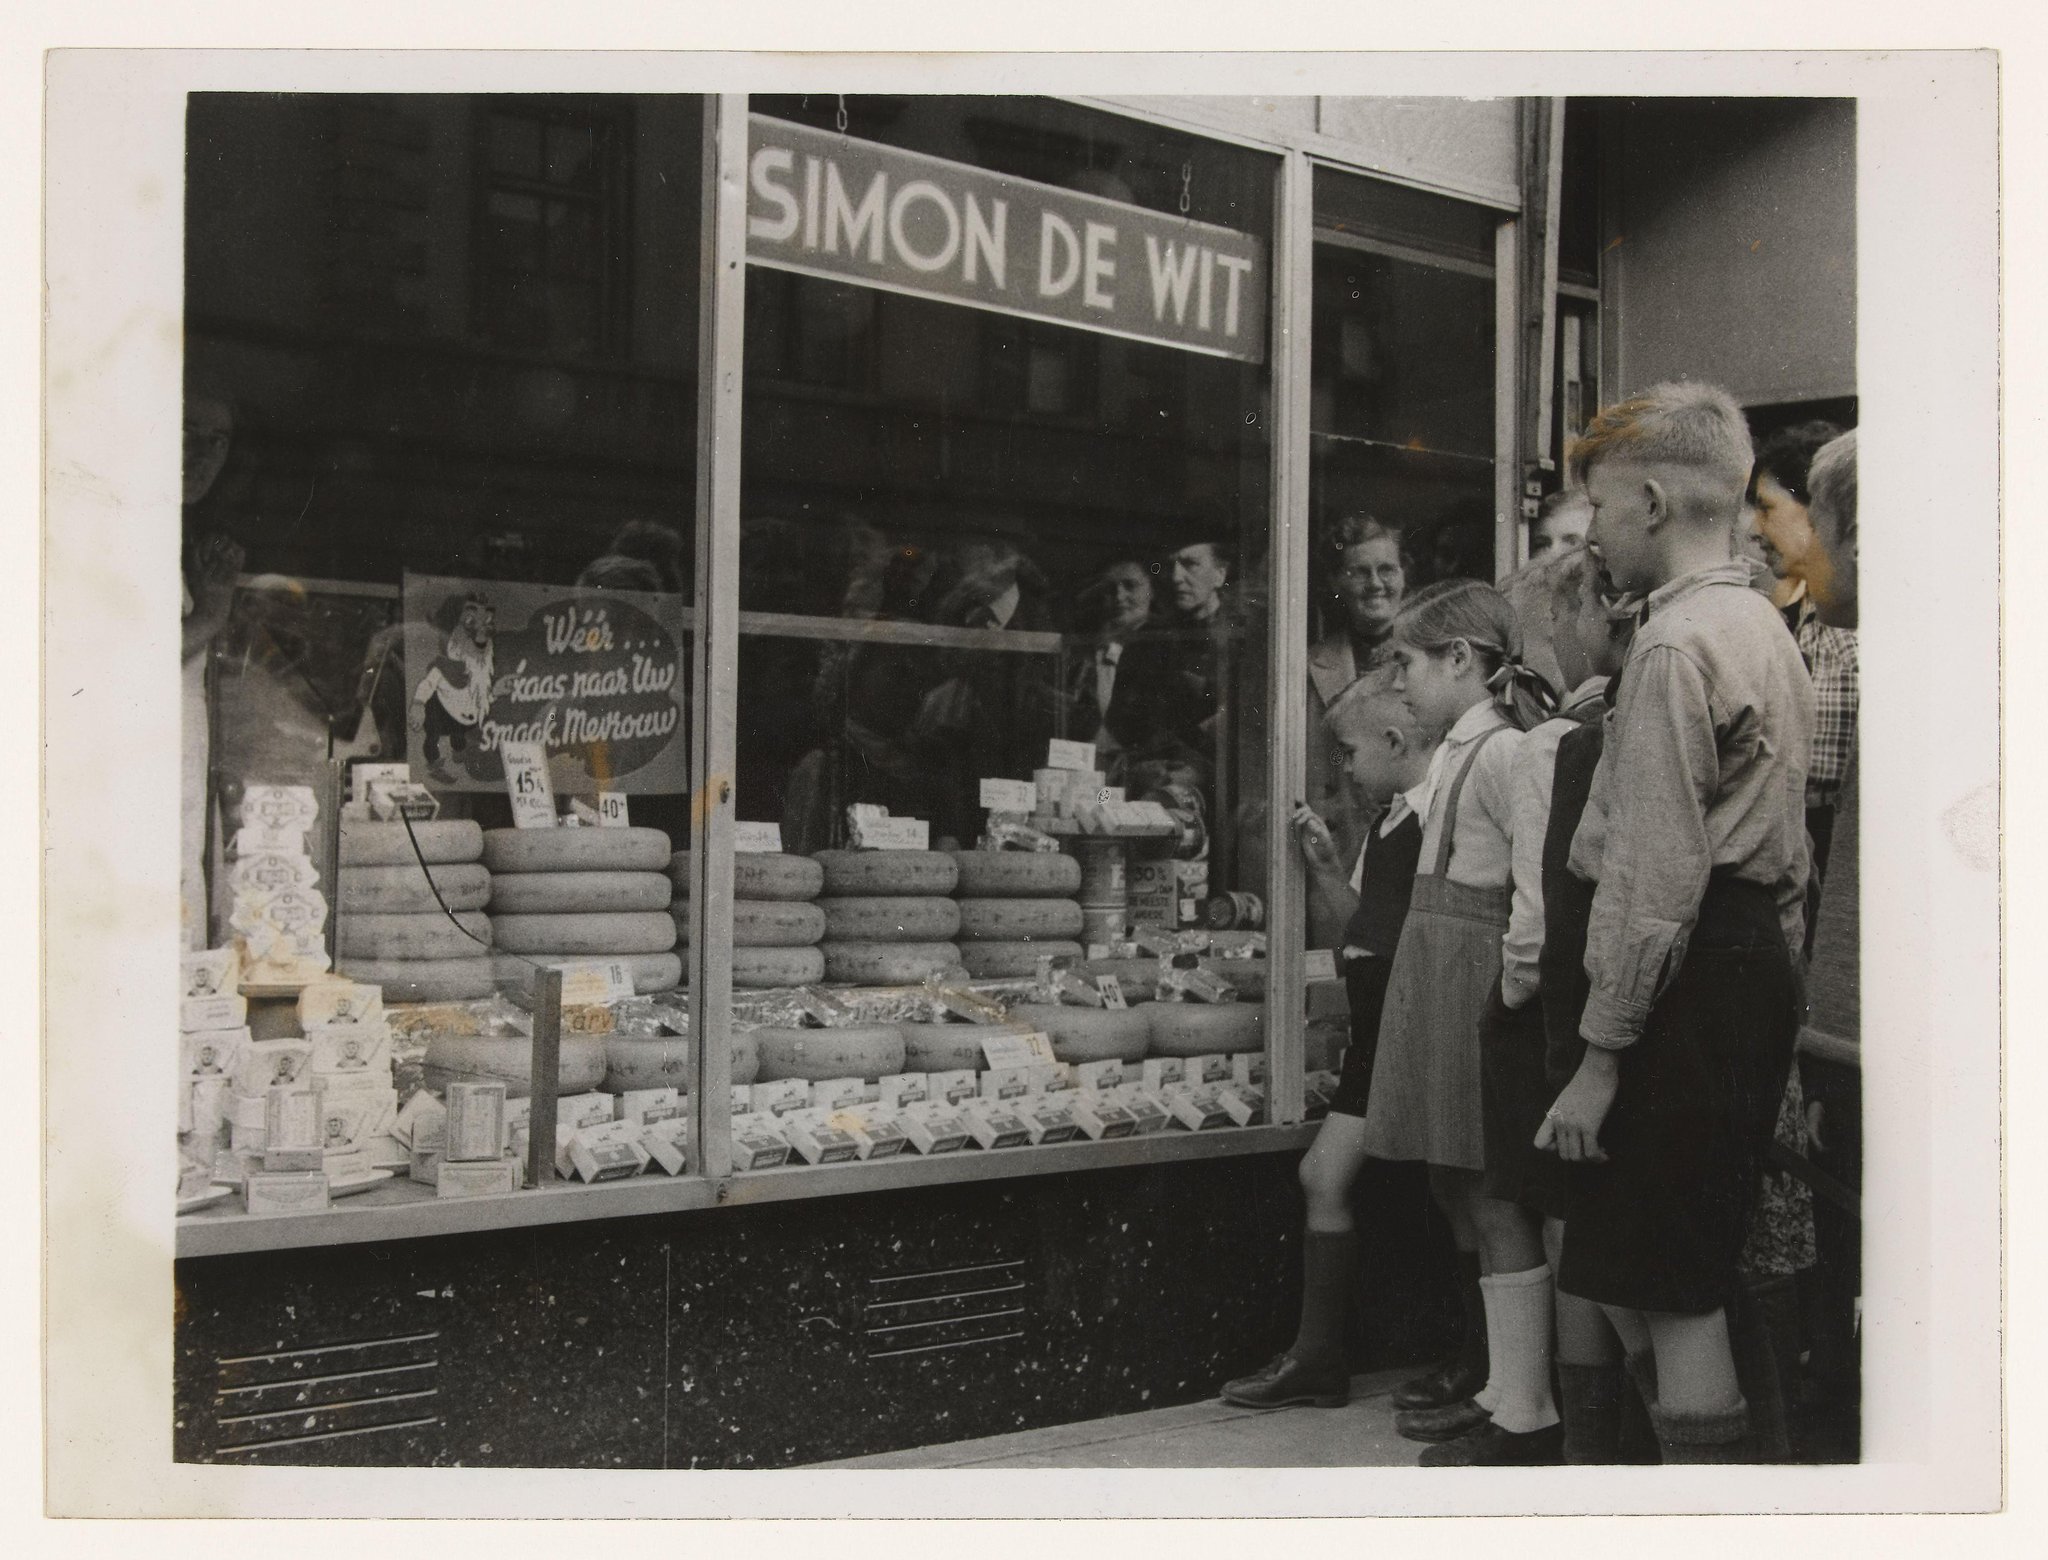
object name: documentary photograph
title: Mensen verlekkeren zich aan de etalage van kaaswinkel Simon de Wit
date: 1945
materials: photographic support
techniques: photography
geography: nijmegen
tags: cheese, shop-window, show-window, nijmegen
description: Kinderen en volwassenen staan vol ongeloof te staren naar de met kazen gevulde etalage van winkel Simon de Wit in Nijmegen. Etenswaren als kaas en margarine waren net na de bevrijding moeilijk (alleen op bonnen) verkrijgbaar. Deze kazen werden geïmporteerd uit Amerika.